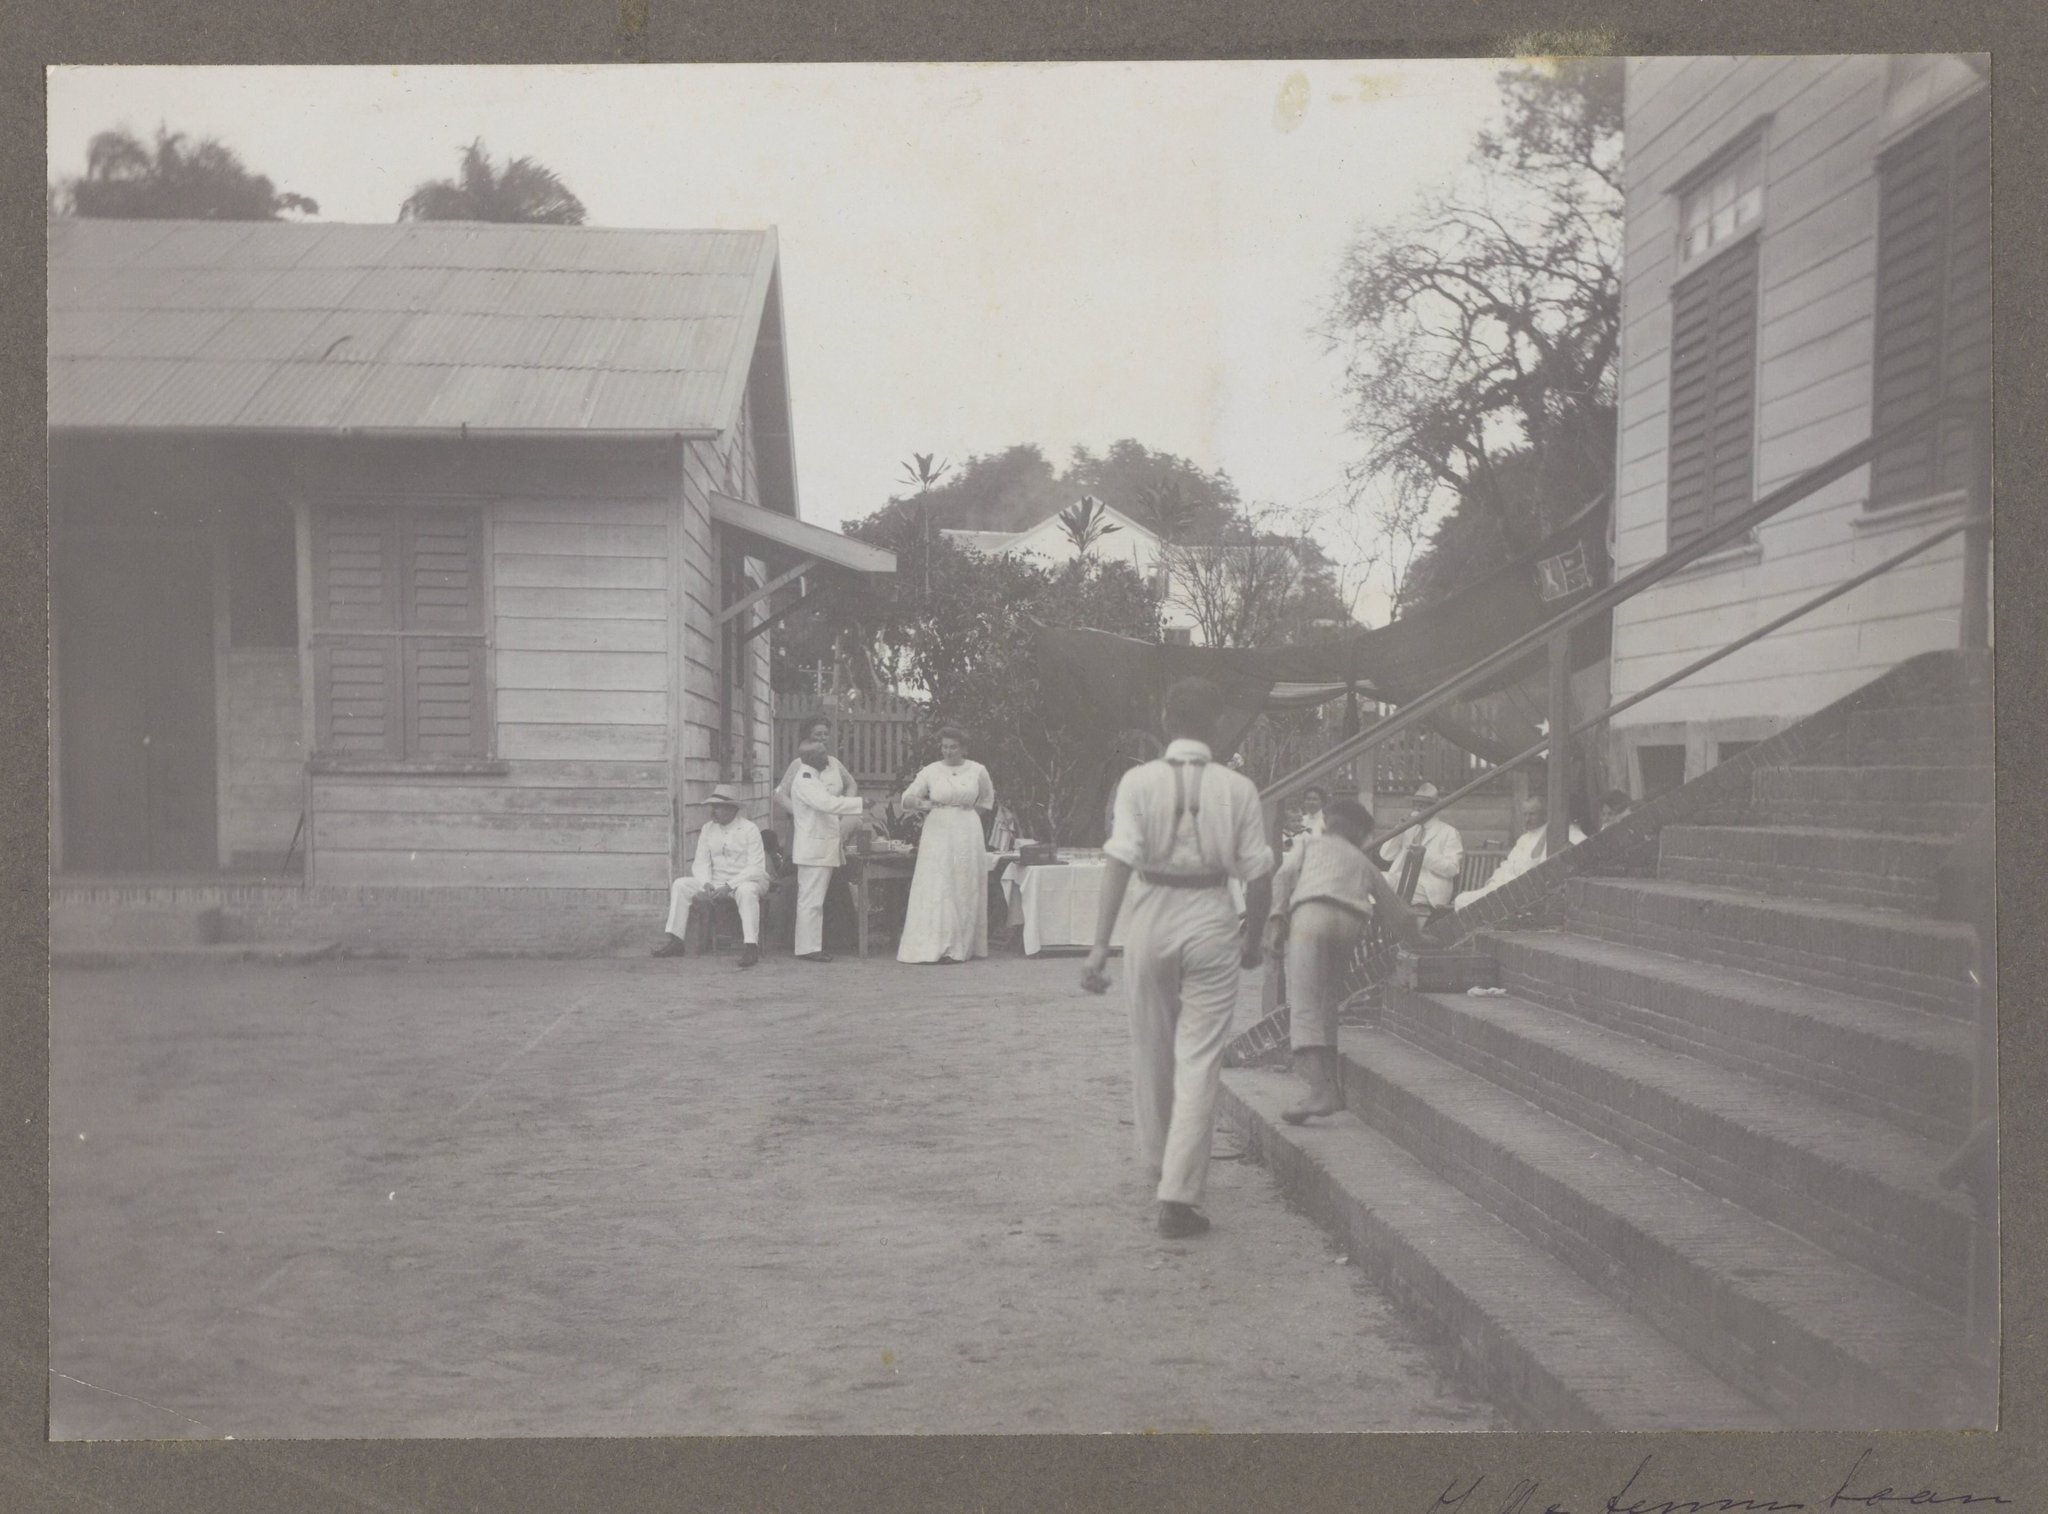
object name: photograph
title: Op de tennisbaan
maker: Anonymous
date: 1910-1914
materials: photographic support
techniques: photography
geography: suriname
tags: tennis, lawn-tennis, suriname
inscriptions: inscription: ‘op de tennis baan’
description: Een groep mensen, waaronder waarschijnlijk leden van de familie Gonggrijp, op de tennisbaan in Paramaribo. Onderdeel van een groep van elf albumbladen met familiefoto's van de familie Gonggrijp in Suriname, ca. 1912.